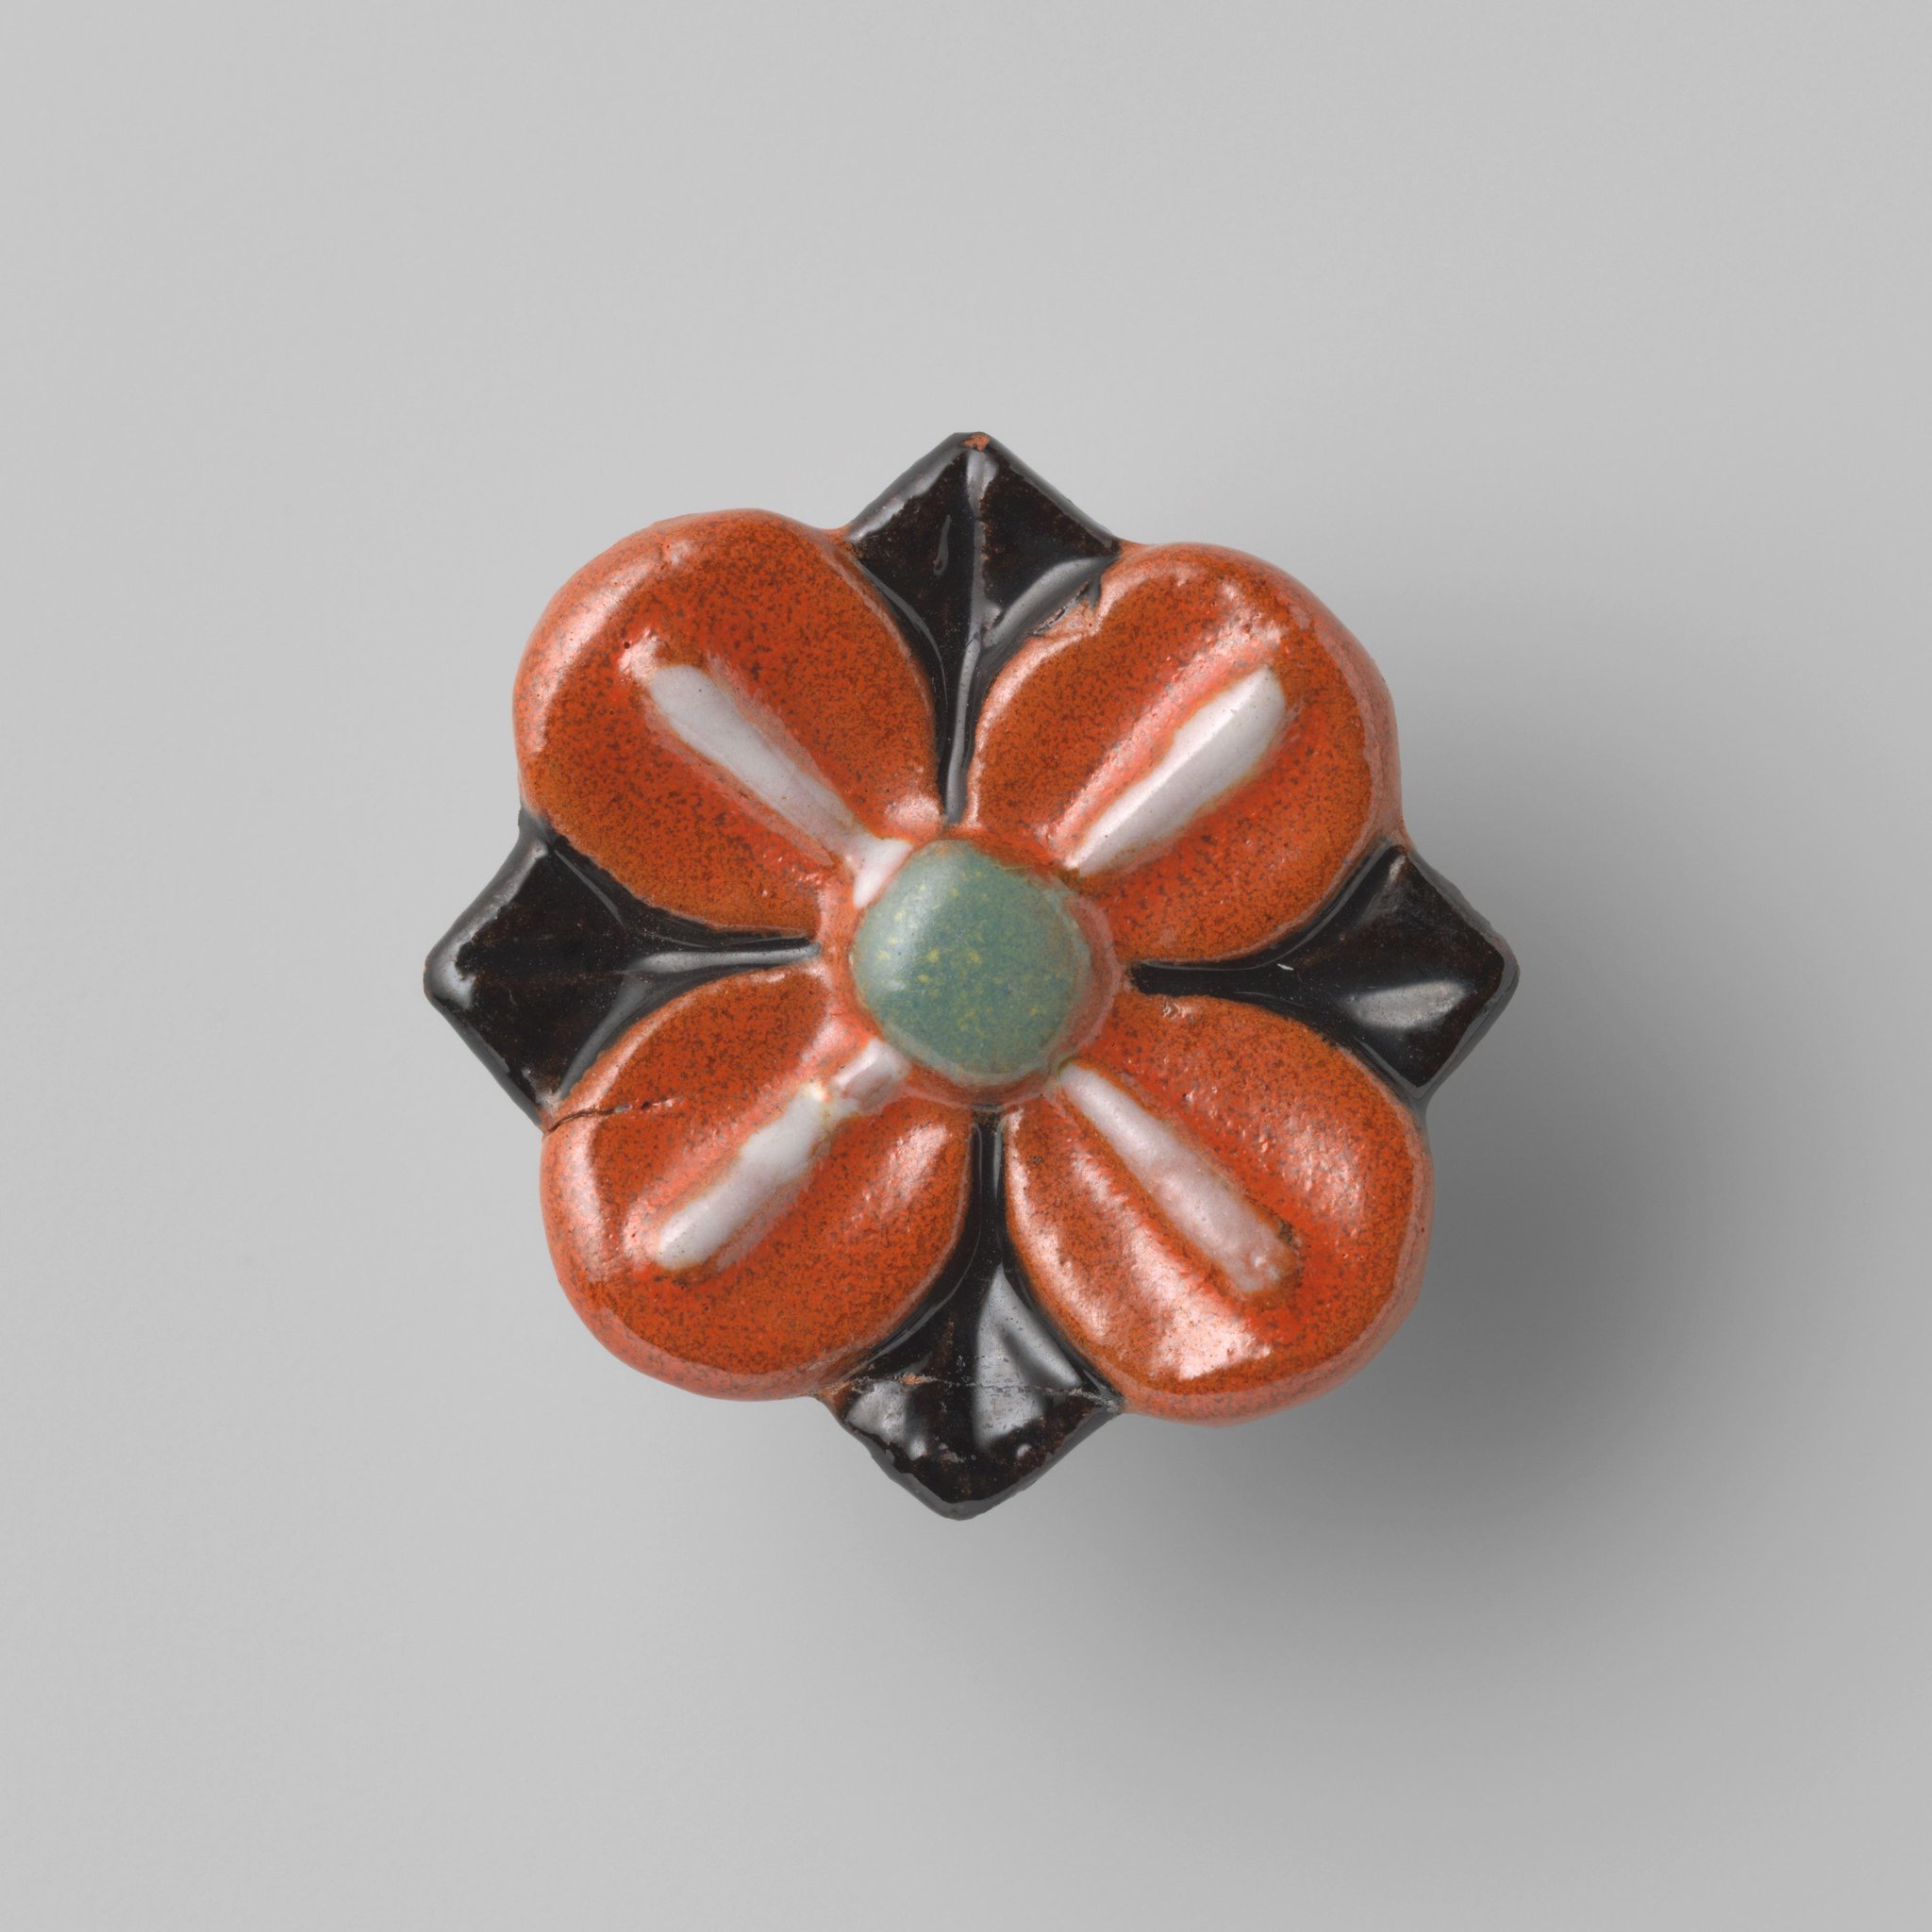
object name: brooch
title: Broche van keramiek met een bloem in een vierkant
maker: Anonymous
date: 1900-1990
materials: ceramic, glue, metal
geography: tegelen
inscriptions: : ‘TEGELSCHE KERAMIEK HANDWERK’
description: Broche van keramiek met een bloem met witte blaadjes en een groen hart in een zwart vierkant voorzien van een opgelijmde haaksluiting die over het merk aan de achterzijde is geplakt.